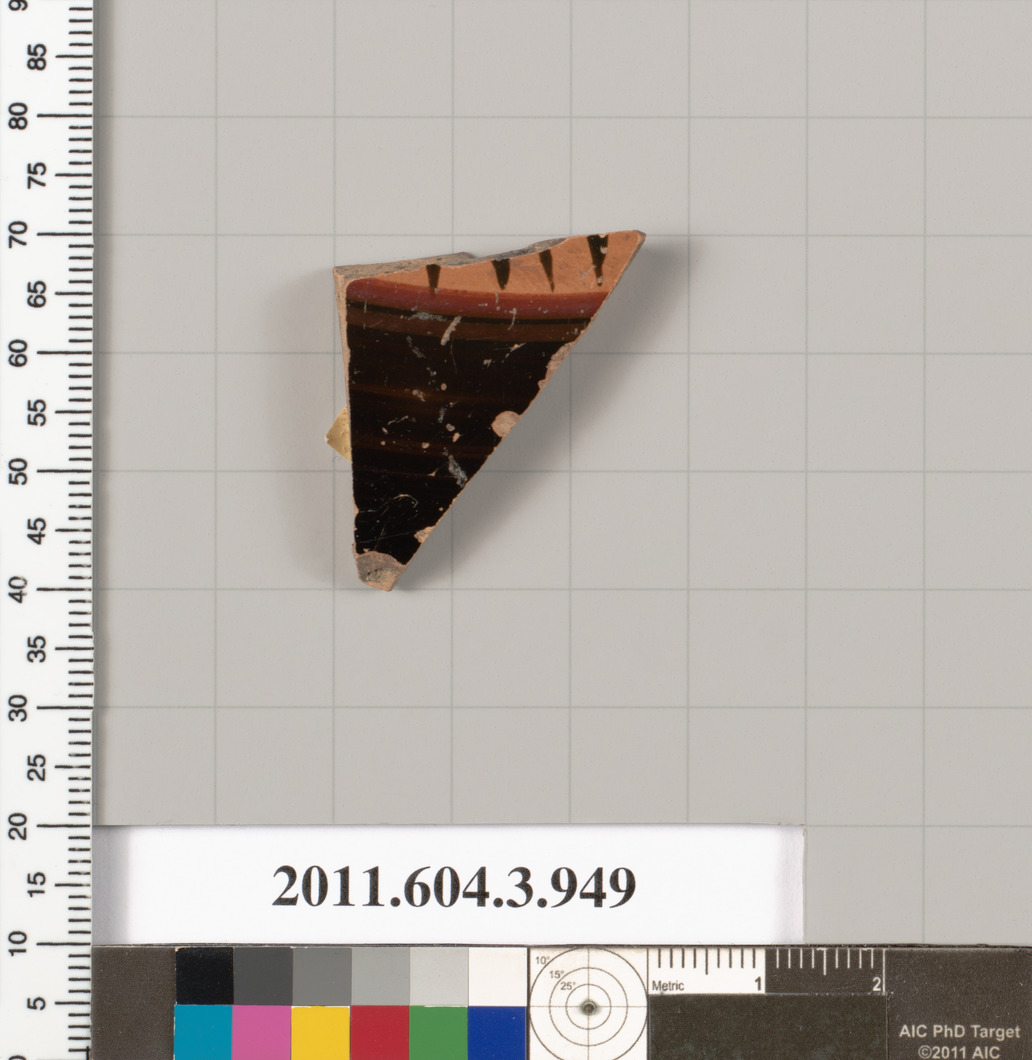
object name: lekanis lid fragment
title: Terracotta fragment of a lekanis lid (covered dish)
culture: greek, attic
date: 600-501 BCE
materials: terracotta